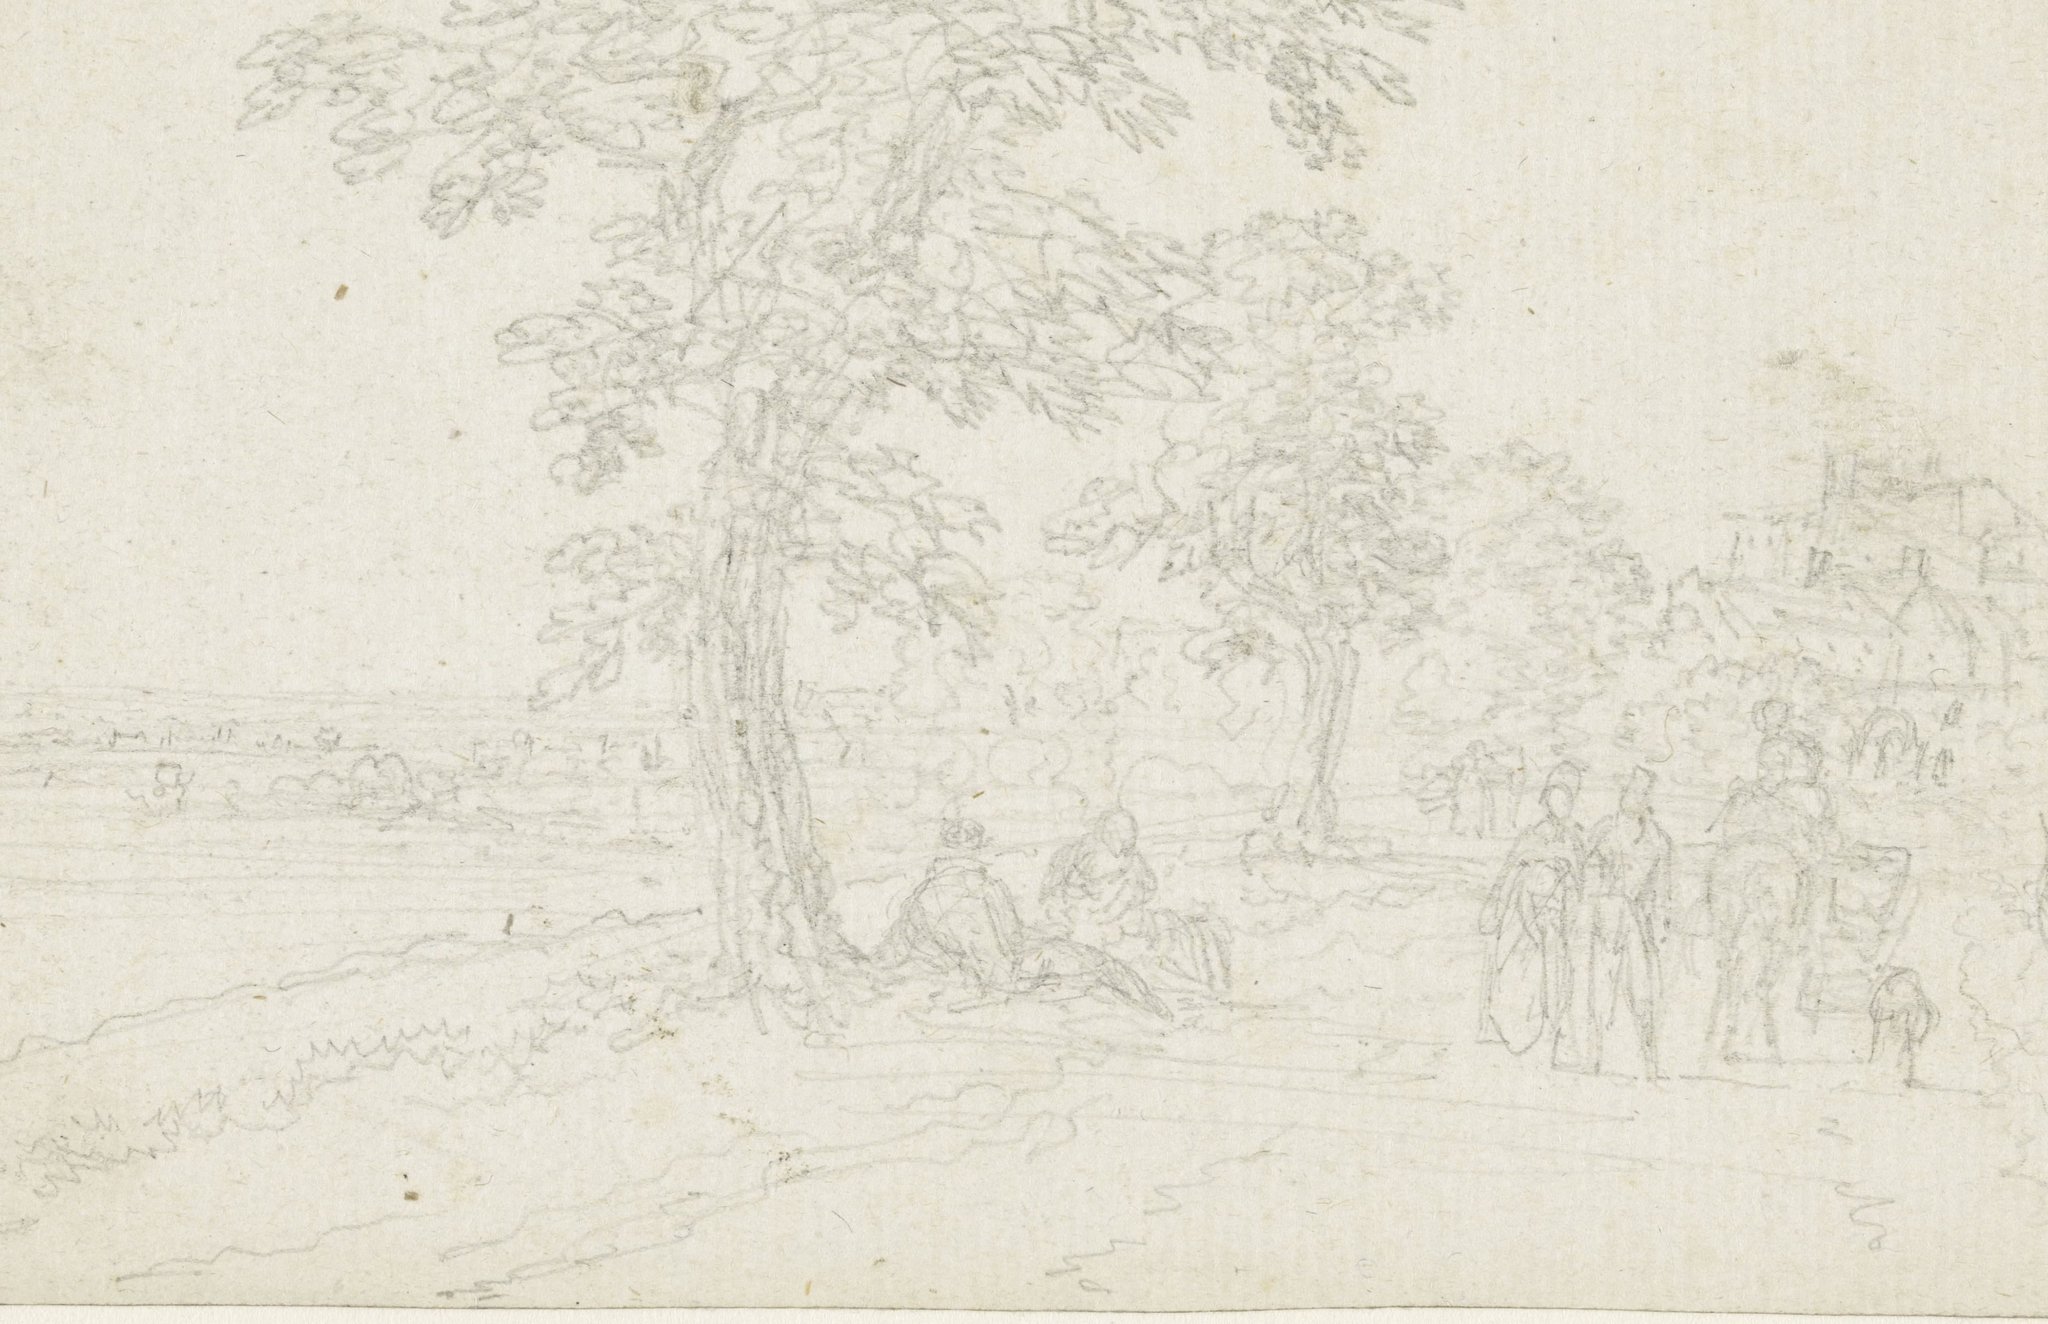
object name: drawing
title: Wandelaars en een rustend paar op een landweg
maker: georges michel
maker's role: draughtsman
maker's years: 1763-1843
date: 1773-1843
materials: paper, pencil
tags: (traveller) resting in the open air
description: Een van 120 tekeningen, afkomstig uit een 19e eeuws album met tekeningen van Georges Michel.